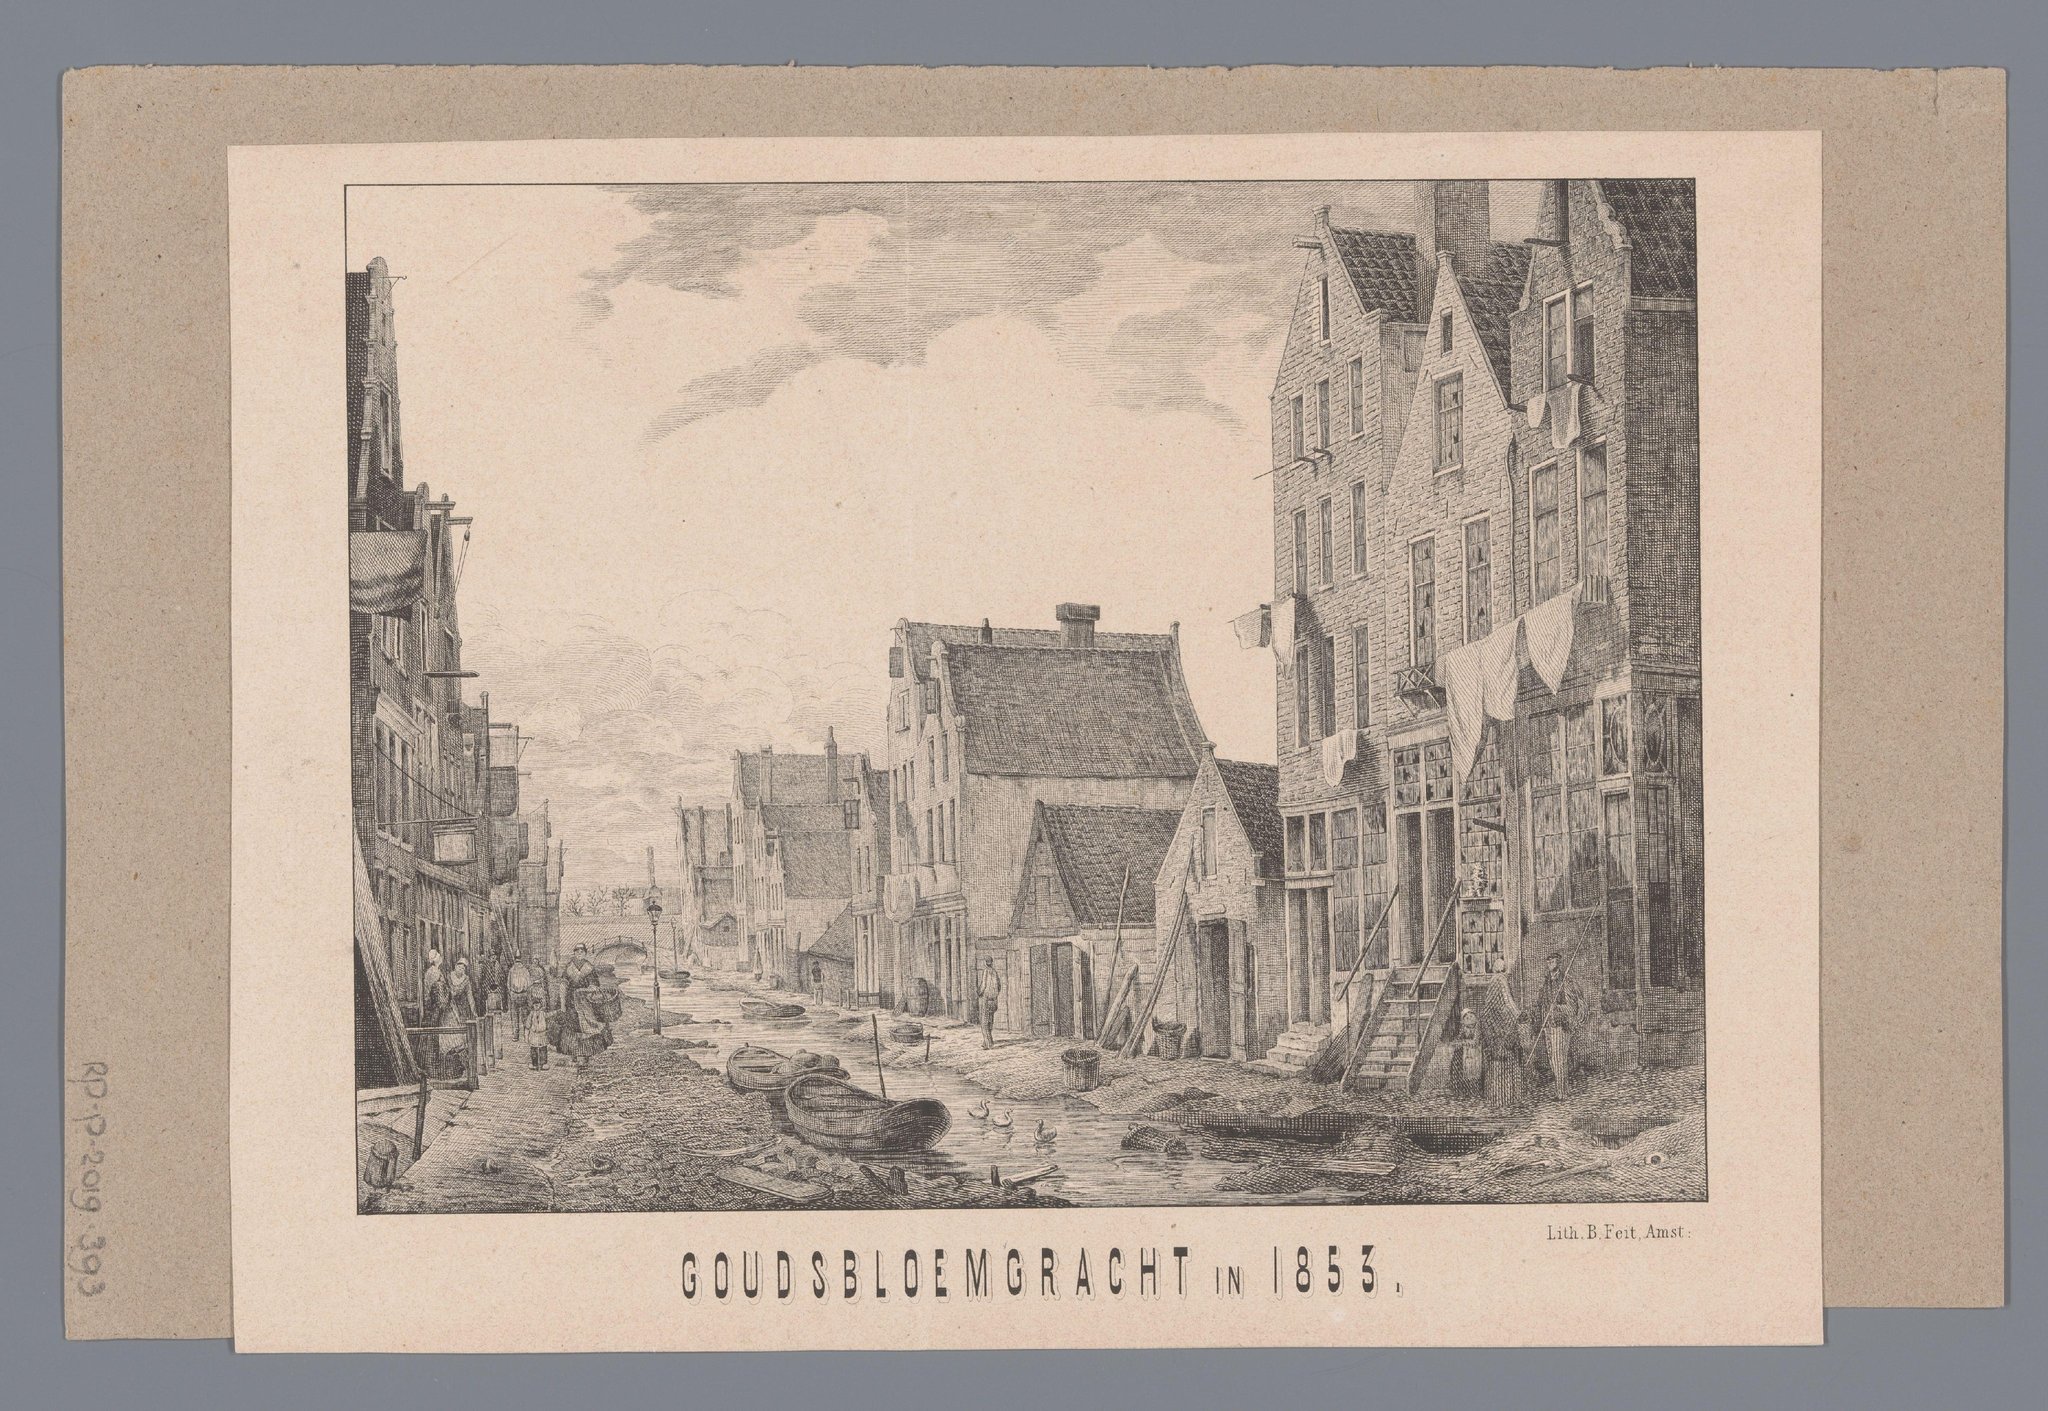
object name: print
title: Goudsbloemgracht in 1853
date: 1851-1883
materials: paper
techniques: lithograph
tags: urban housing, rowing-boat, canoe, etc., bridge in city across river, canal, etc.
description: De Goudsbloemgracht is in 1857 gedempt en tegenwoordig bekend als de Willemsstraat.